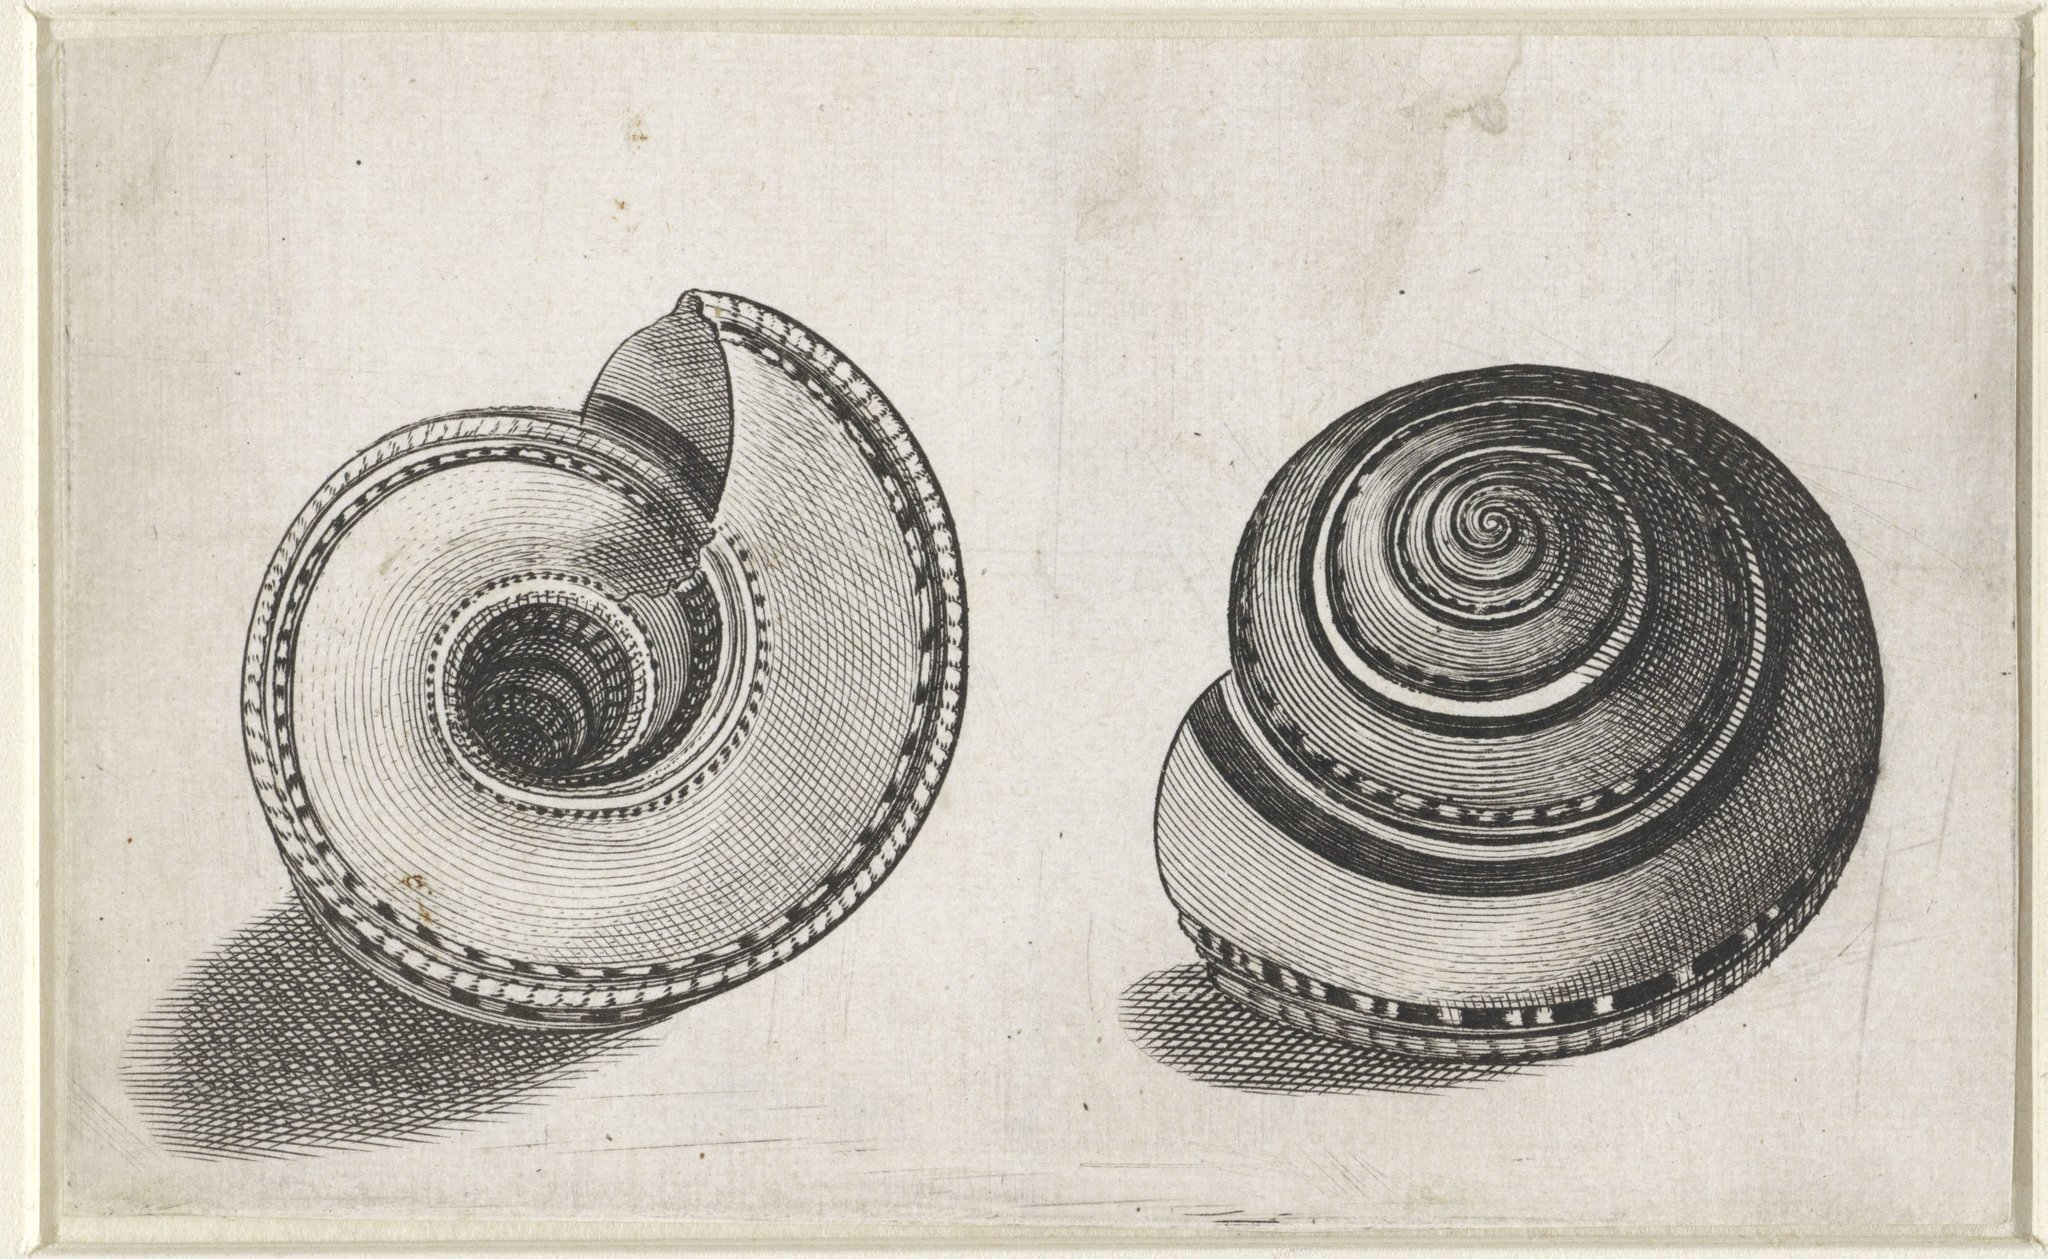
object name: print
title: Schelp, architectonica trochlearis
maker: Anonymous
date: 1644-1702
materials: paper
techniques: etching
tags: molluscs (+ shell, snail-shell etc.)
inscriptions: collector's mark: Lugt 240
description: Kopie naar prent die deel uitmaakt van een 39-delige serie met verschillende soorten schelpen, door Hollar.